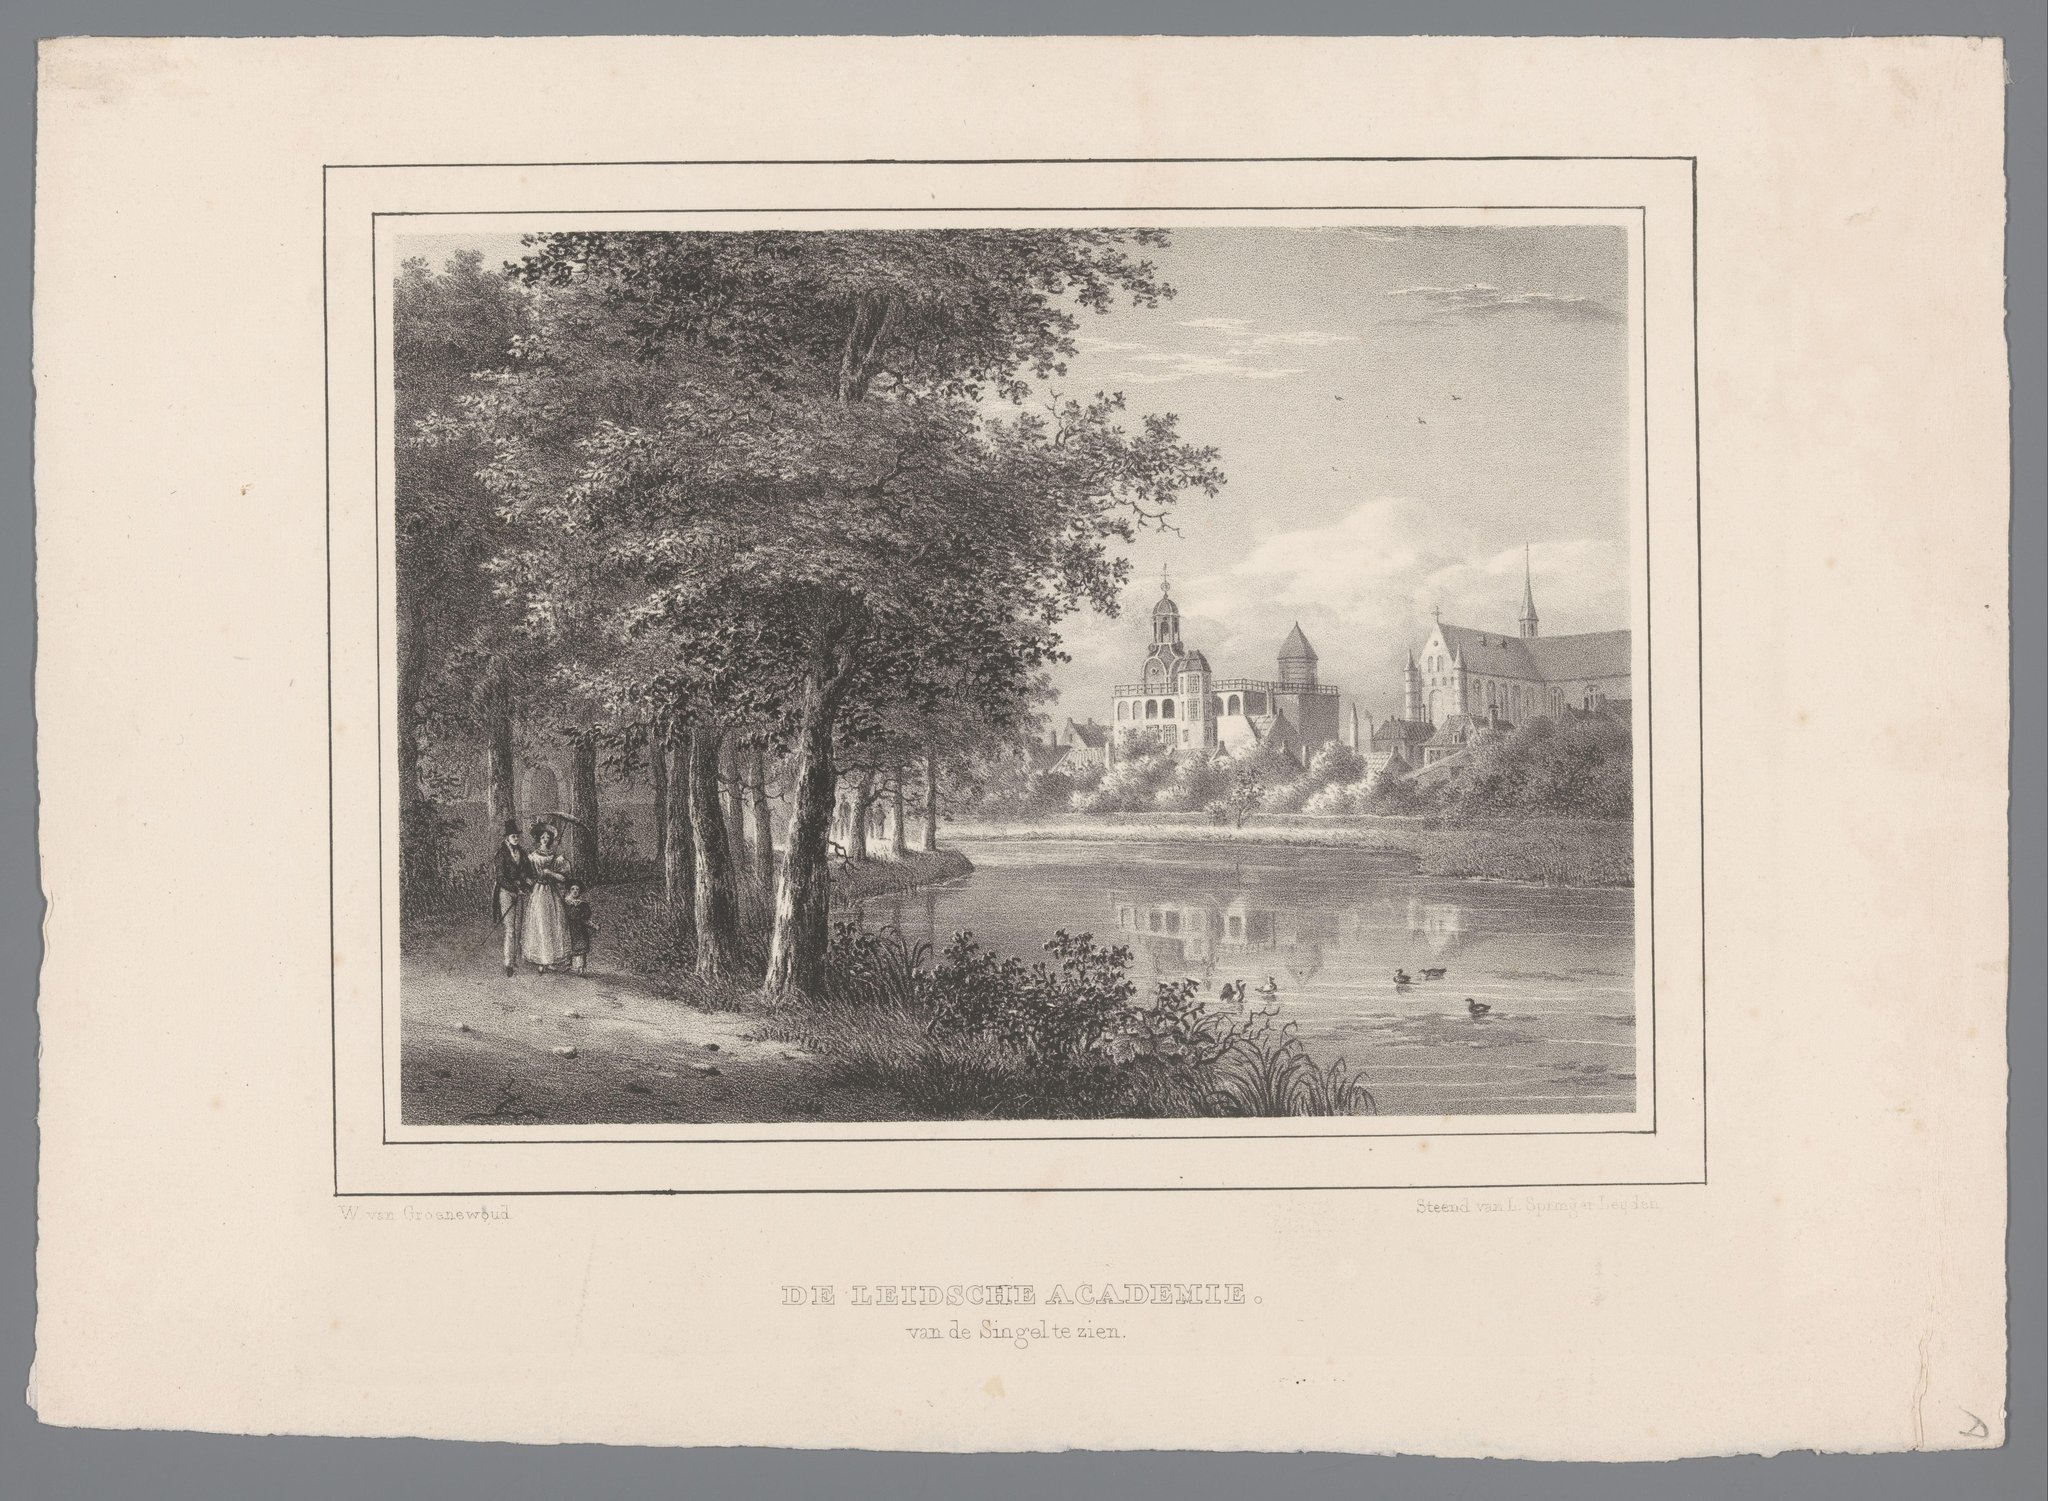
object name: print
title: Gezigten in de omstreeken van Leiden, vervaardigt ter steendrukkerij van L. Springer te Leiden 1843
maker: leendert springer (i)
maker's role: draughtsman, painter, print maker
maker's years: 1789-1871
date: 1843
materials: paper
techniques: lithograph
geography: netherlands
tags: canals, waters (in city), university